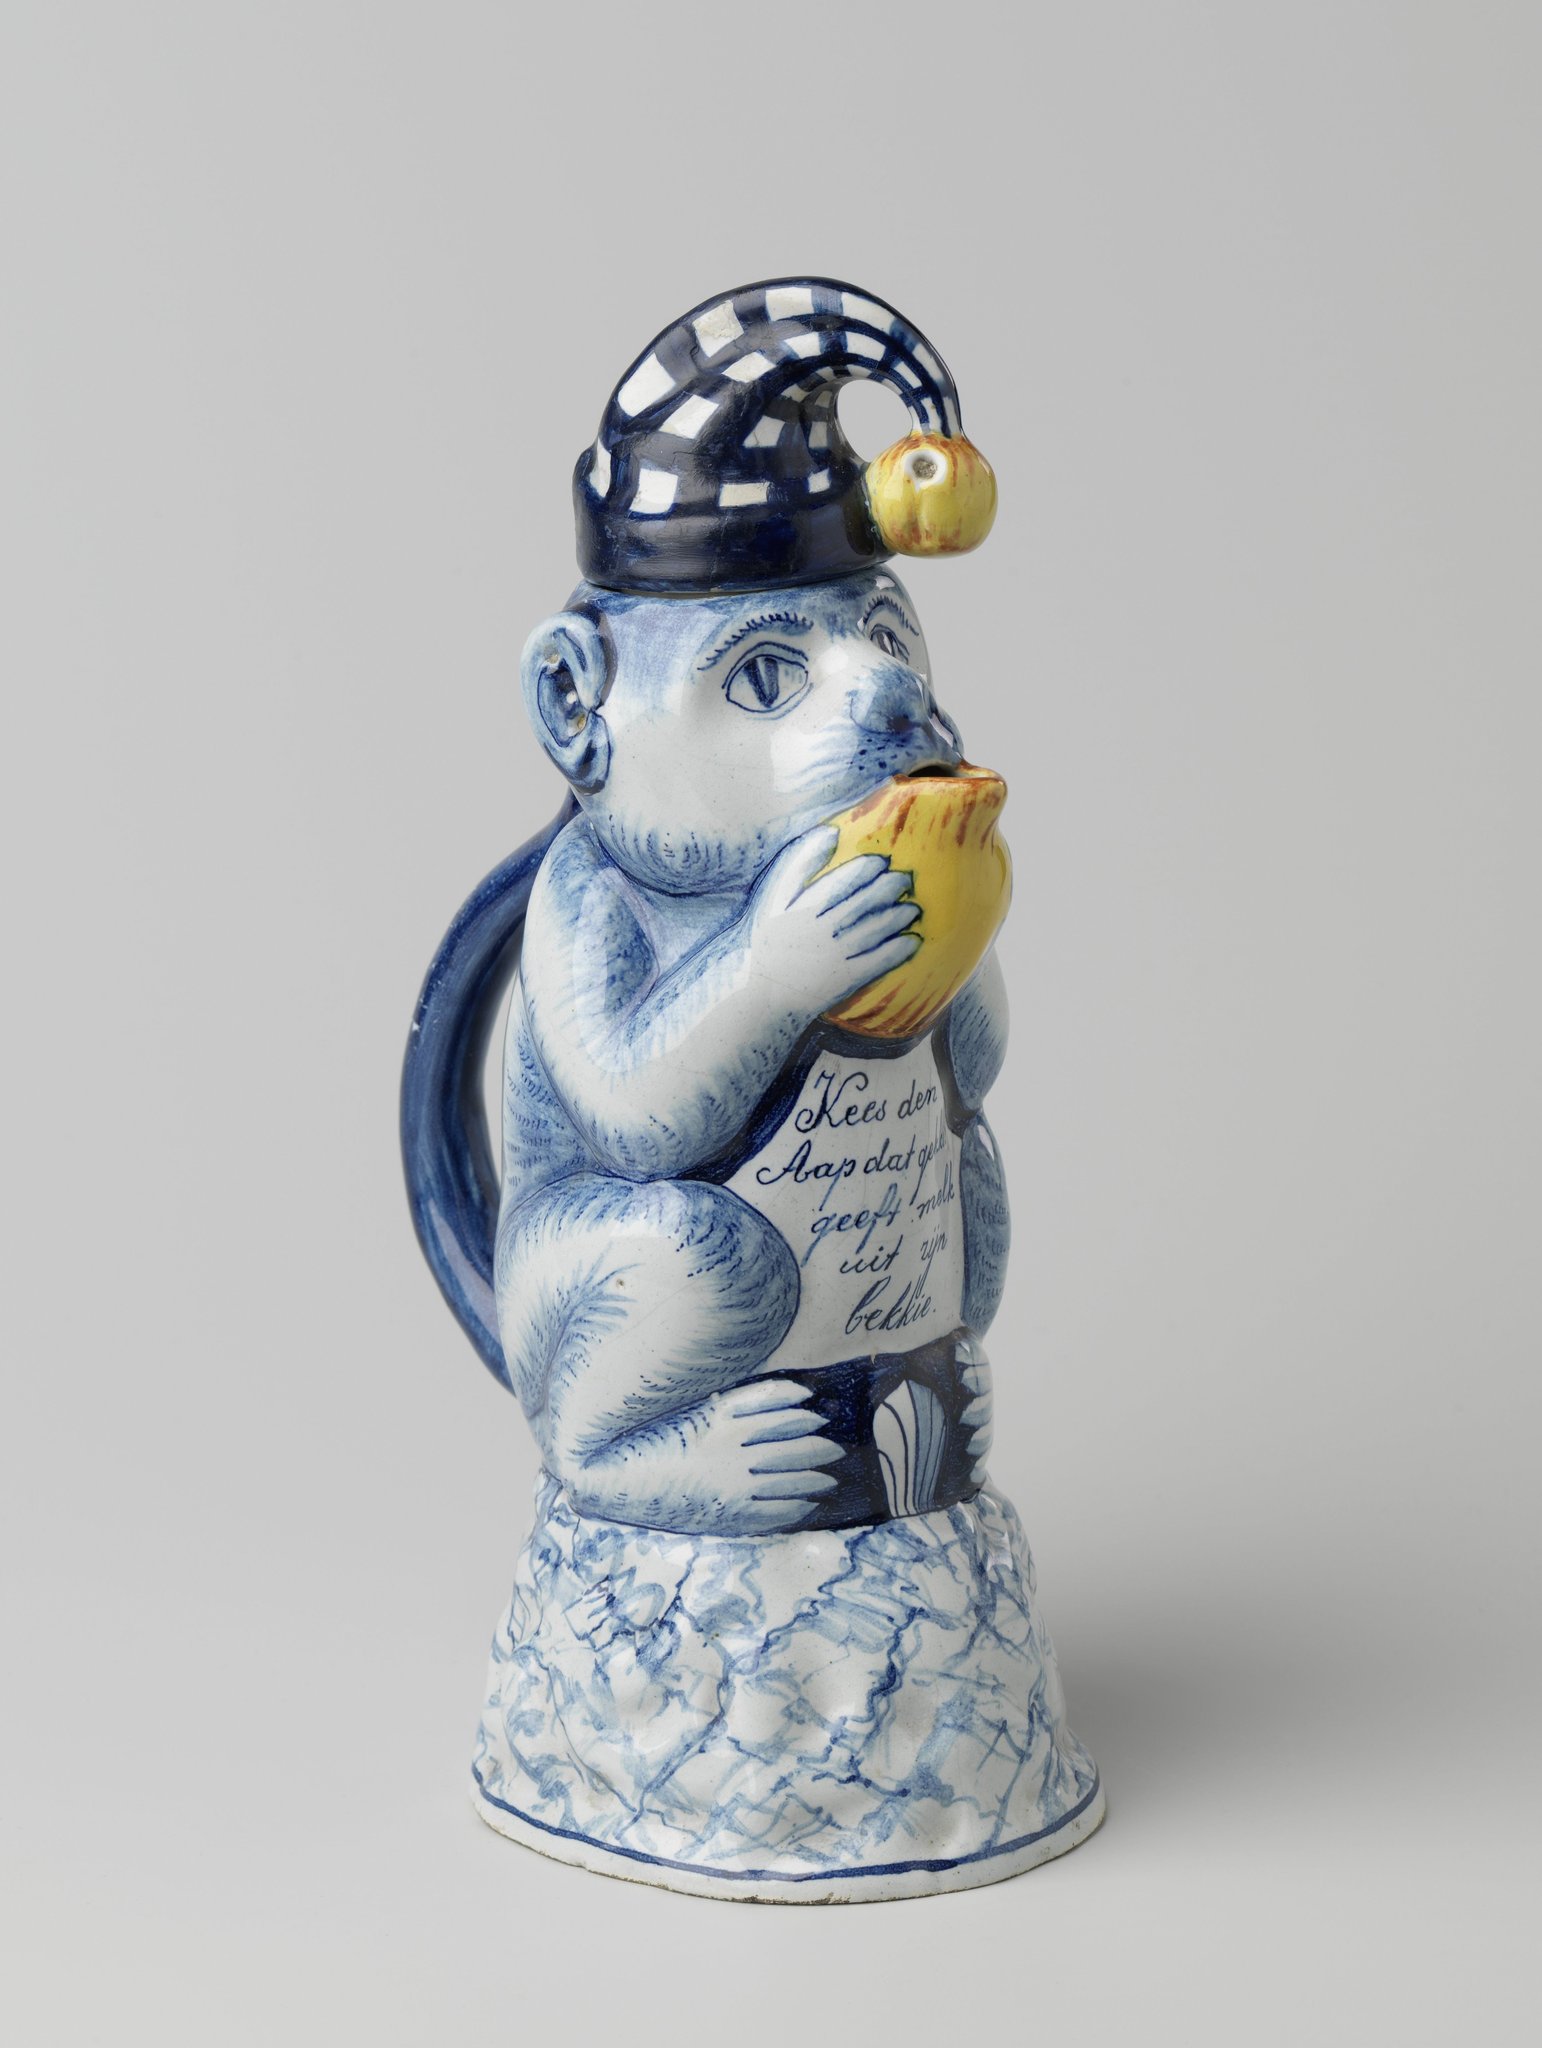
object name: ewer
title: Kan in de vorm van een gemutste aap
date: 1900-1925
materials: earthenware, glaze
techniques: painted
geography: makkum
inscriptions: inscription: ‘Kees den/ Aap dat gekkie/ geeft melk/ uit zijn/ bekkie.’, mark: ‘twee gekruisde t's’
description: Kan van blauw en geel beschilderde faience in de vorm van een aap. De aap draagt een muts en de muts is het deksel. De staart van de aap is het handvat en zijn gele bek de schenktuit. Op de buik van de aap staat een spreuk:" Kees den Aap...". De kan is gemerkt.